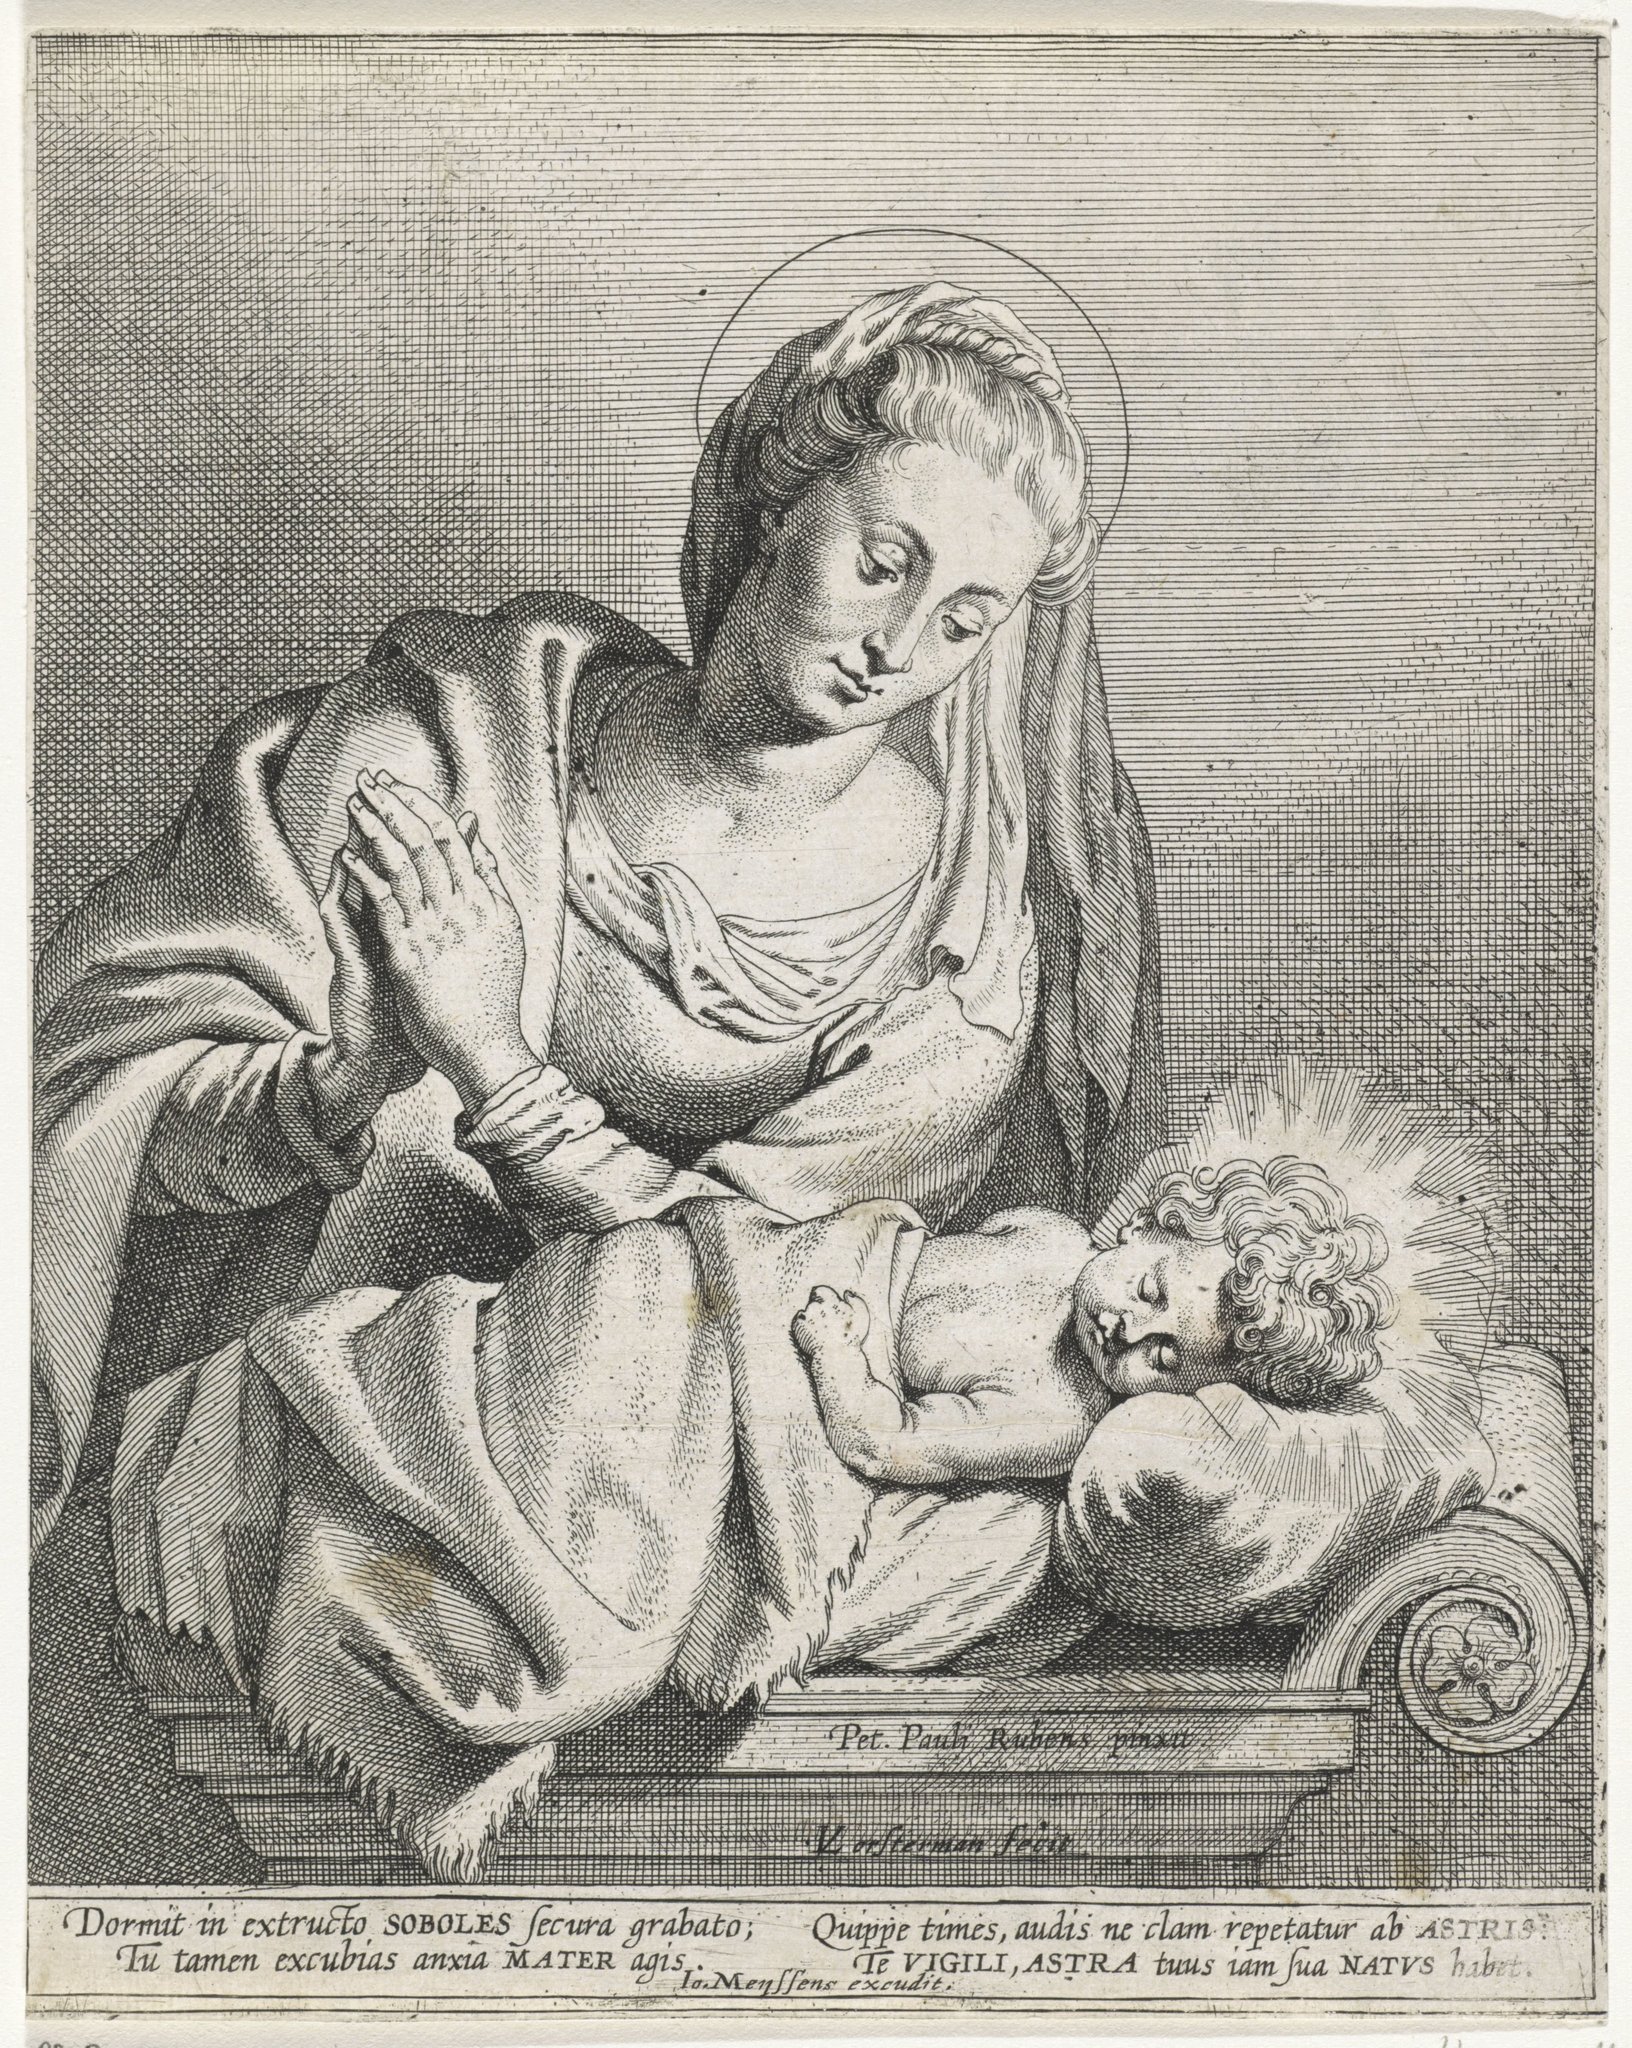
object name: print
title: Maria in aanbidding bij het Christuskind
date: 1640-1670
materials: paper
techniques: engraving, etching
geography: antwerp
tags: adoration of the christ-child by mary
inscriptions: collector's mark: Lugt 240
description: Maria met gevouwen handen in aanbidding bij het slapende Christuskind.